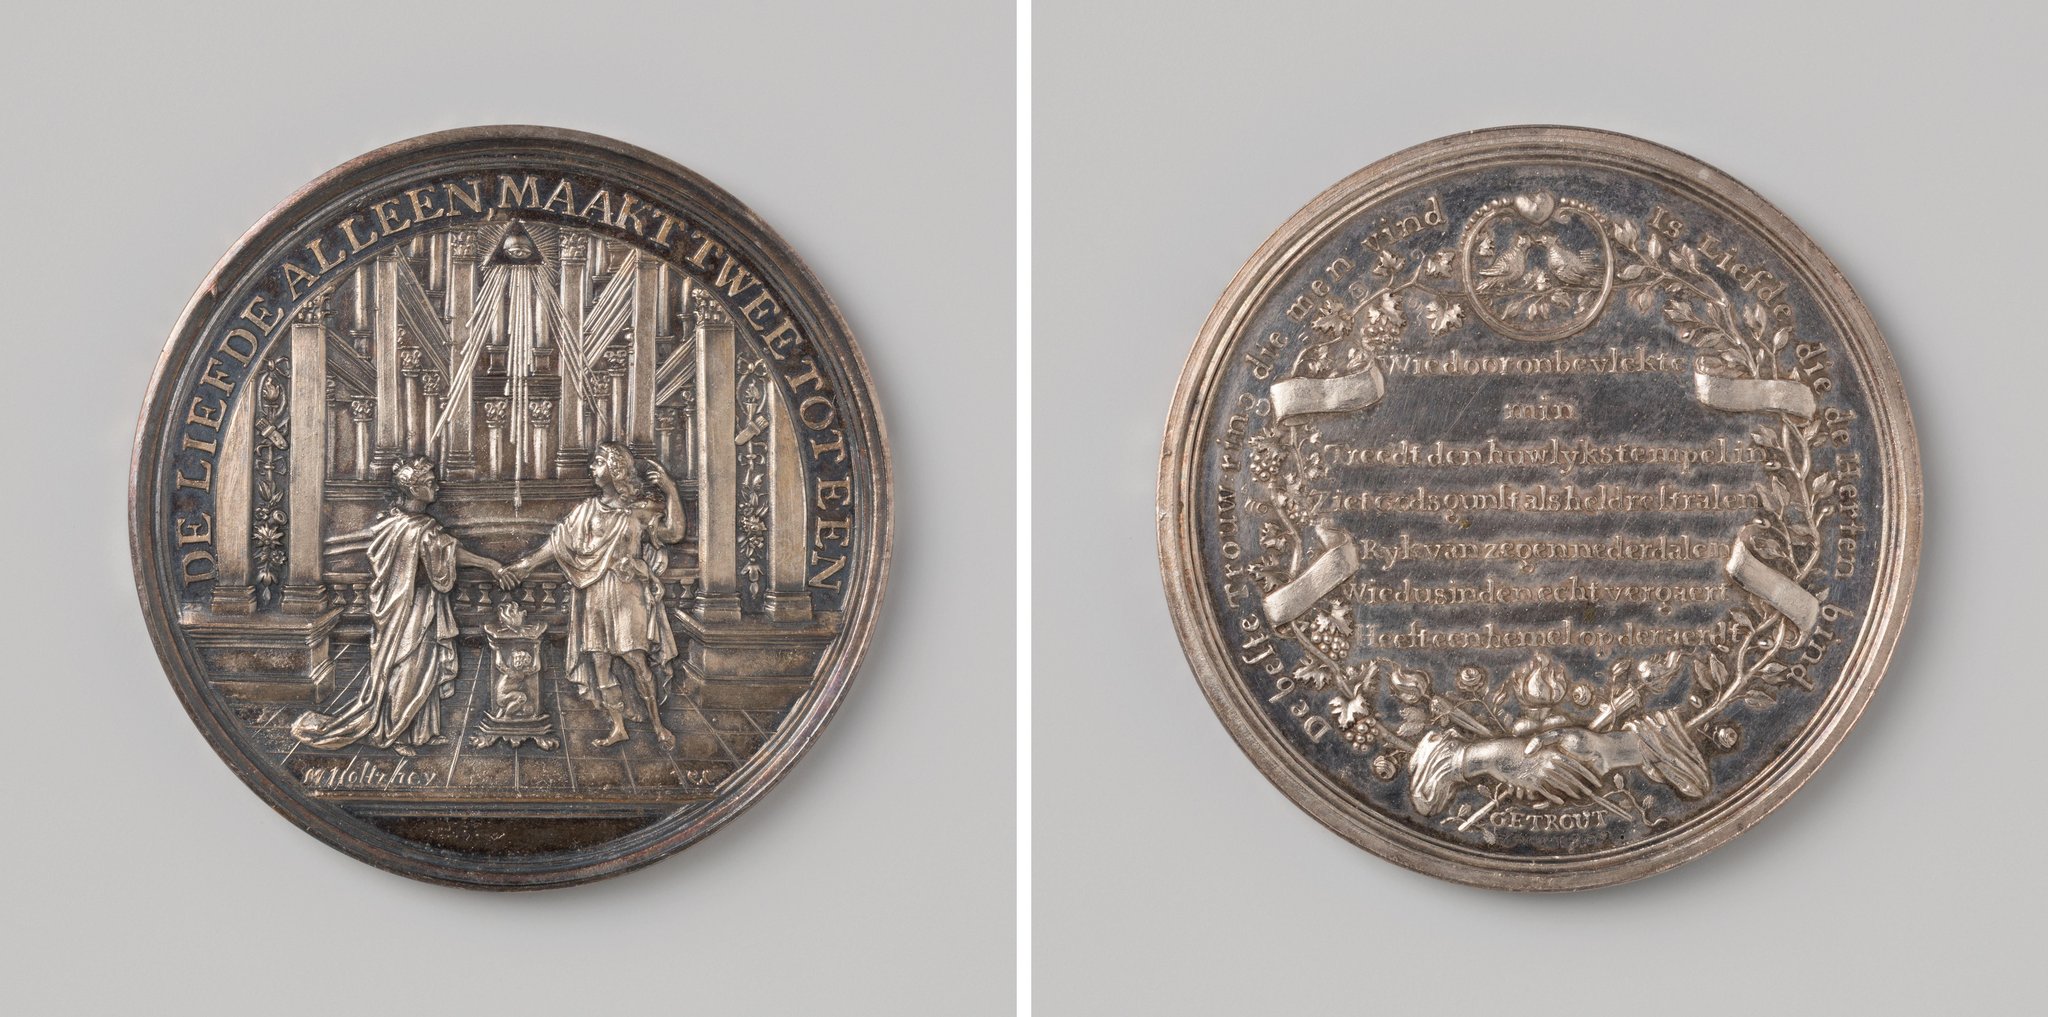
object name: family medal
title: Wedding of Hendrik Tigges and Magdalena Anna Poursoy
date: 1802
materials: silver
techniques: engraving, striking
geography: amsterdam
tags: hendrik tigges, magdalena anna poursoy, jan christoffel tigges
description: In the past, important events were graced with a medal, especially in well-to-do families. The occasion for this was usually a birth, wedding, or death. These medals not only remained in the family as a memento, but were also given to the guests at the baptism, wedding party, or funeral. Sometimes they were purely private in character, such as the gold medal a grandfather gave to his grandson.